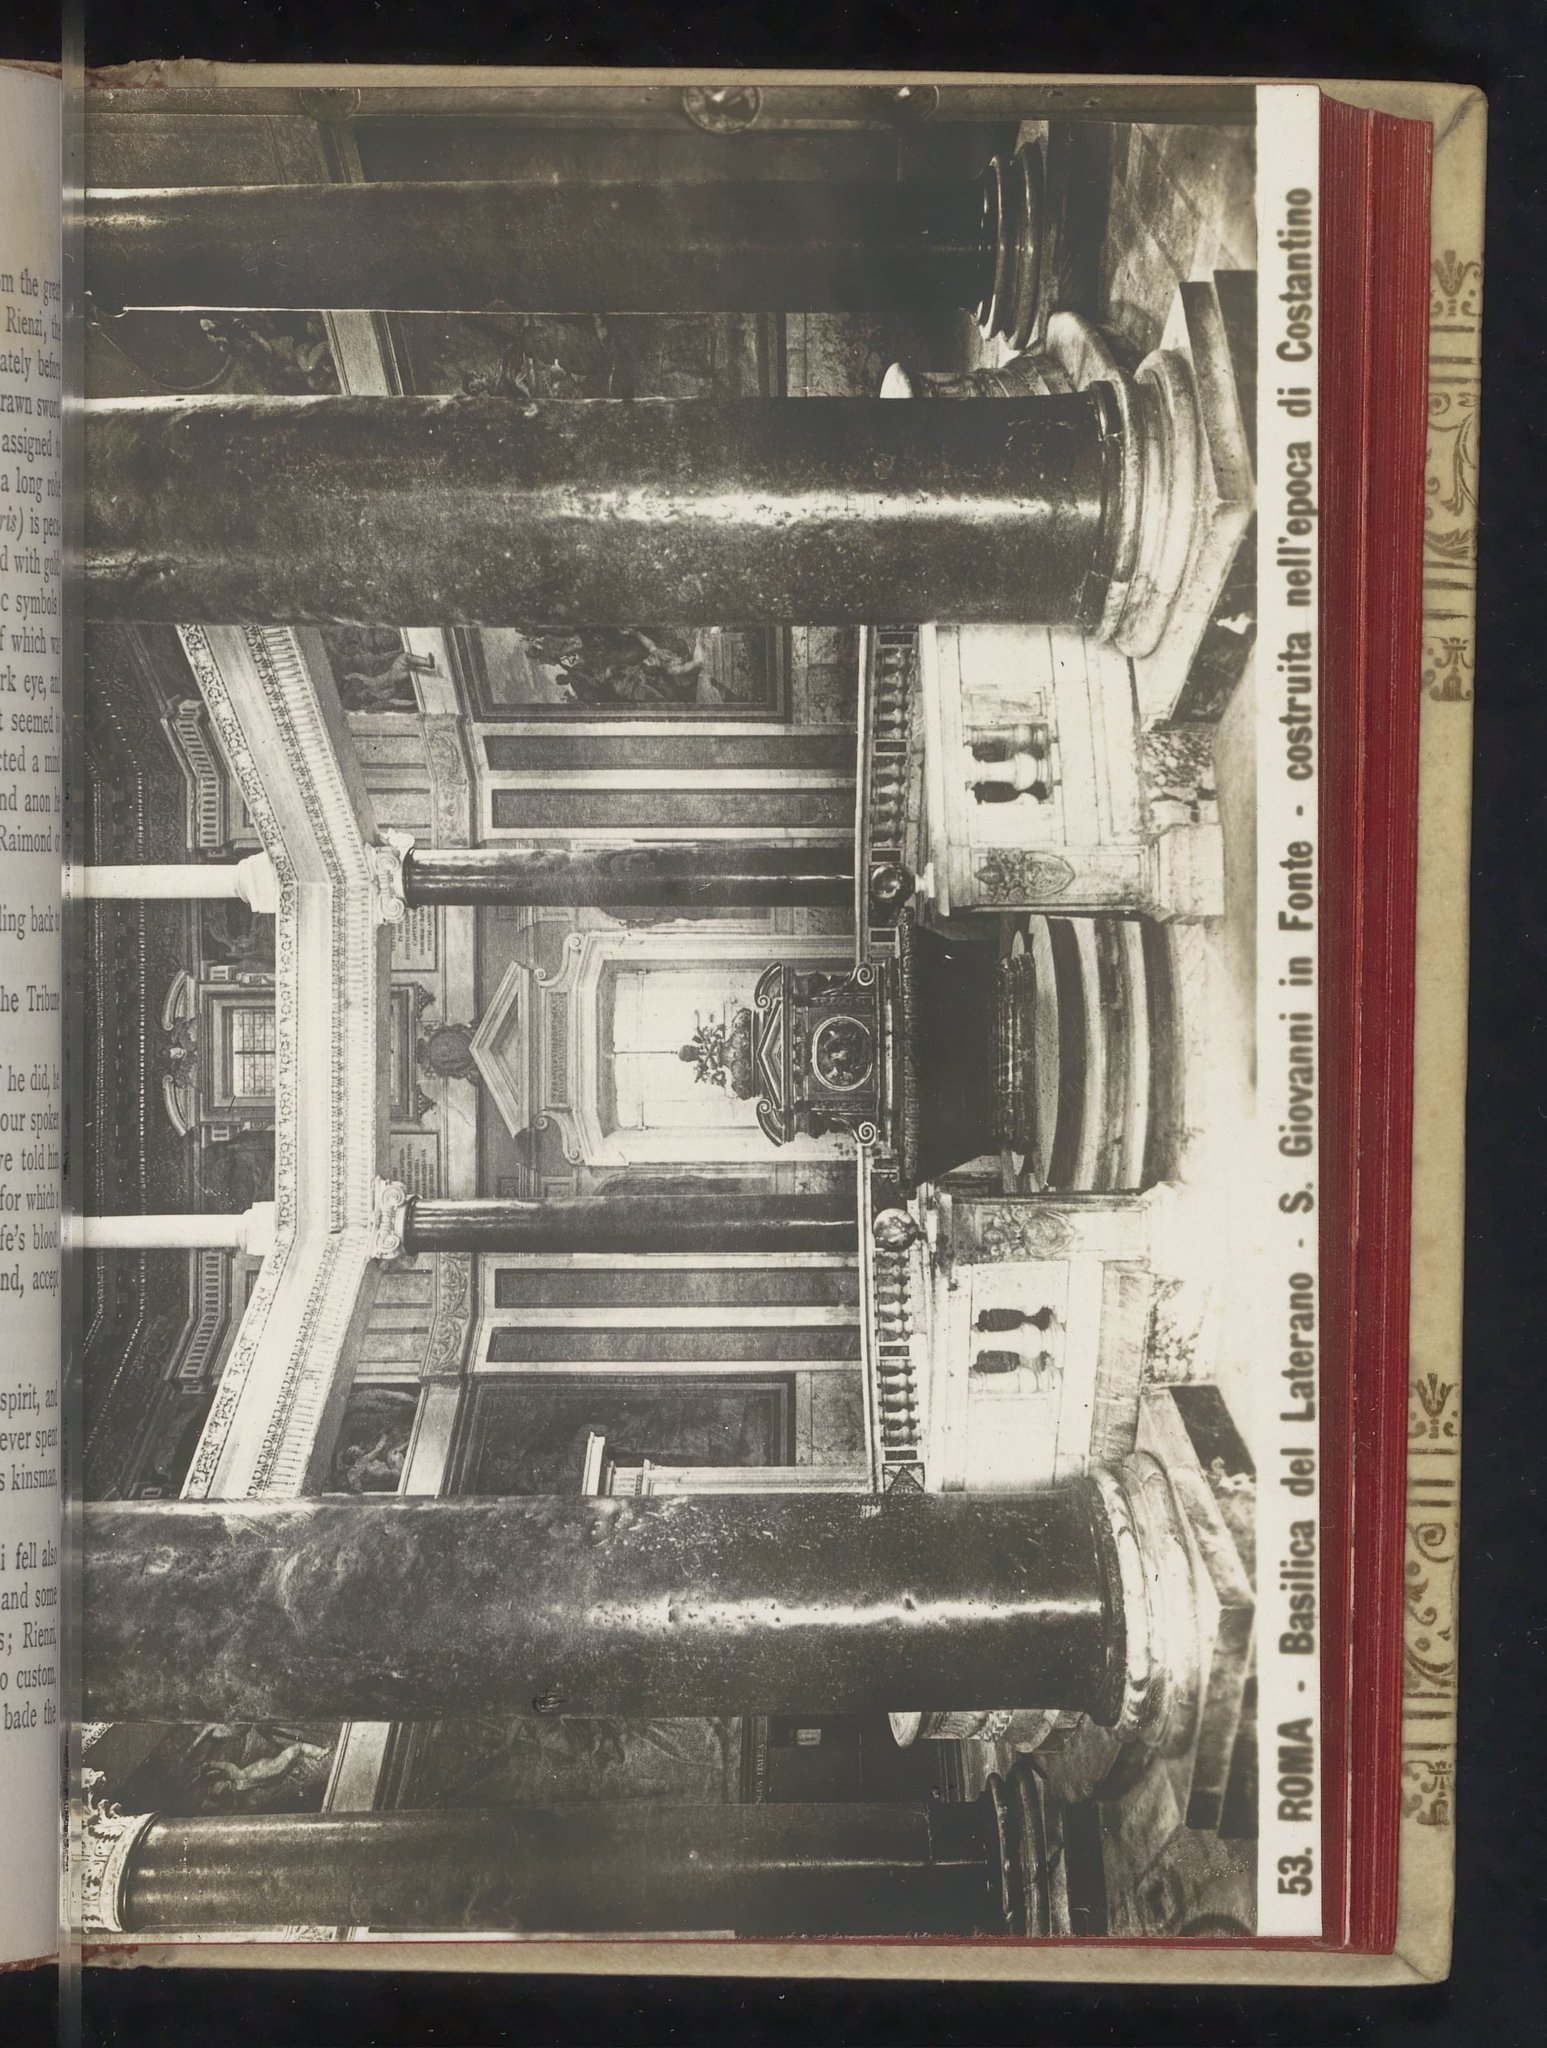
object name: page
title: Roma - Basilica del Laterano - S. Giovanni in Fonte - contruita nell'epoca di Constantino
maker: Anonymous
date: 1895-1915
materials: photographic support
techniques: gelatin silver print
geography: baptisterium van lateranen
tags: baptismal font, interior ~ representation of a building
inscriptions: number: ‘53.’